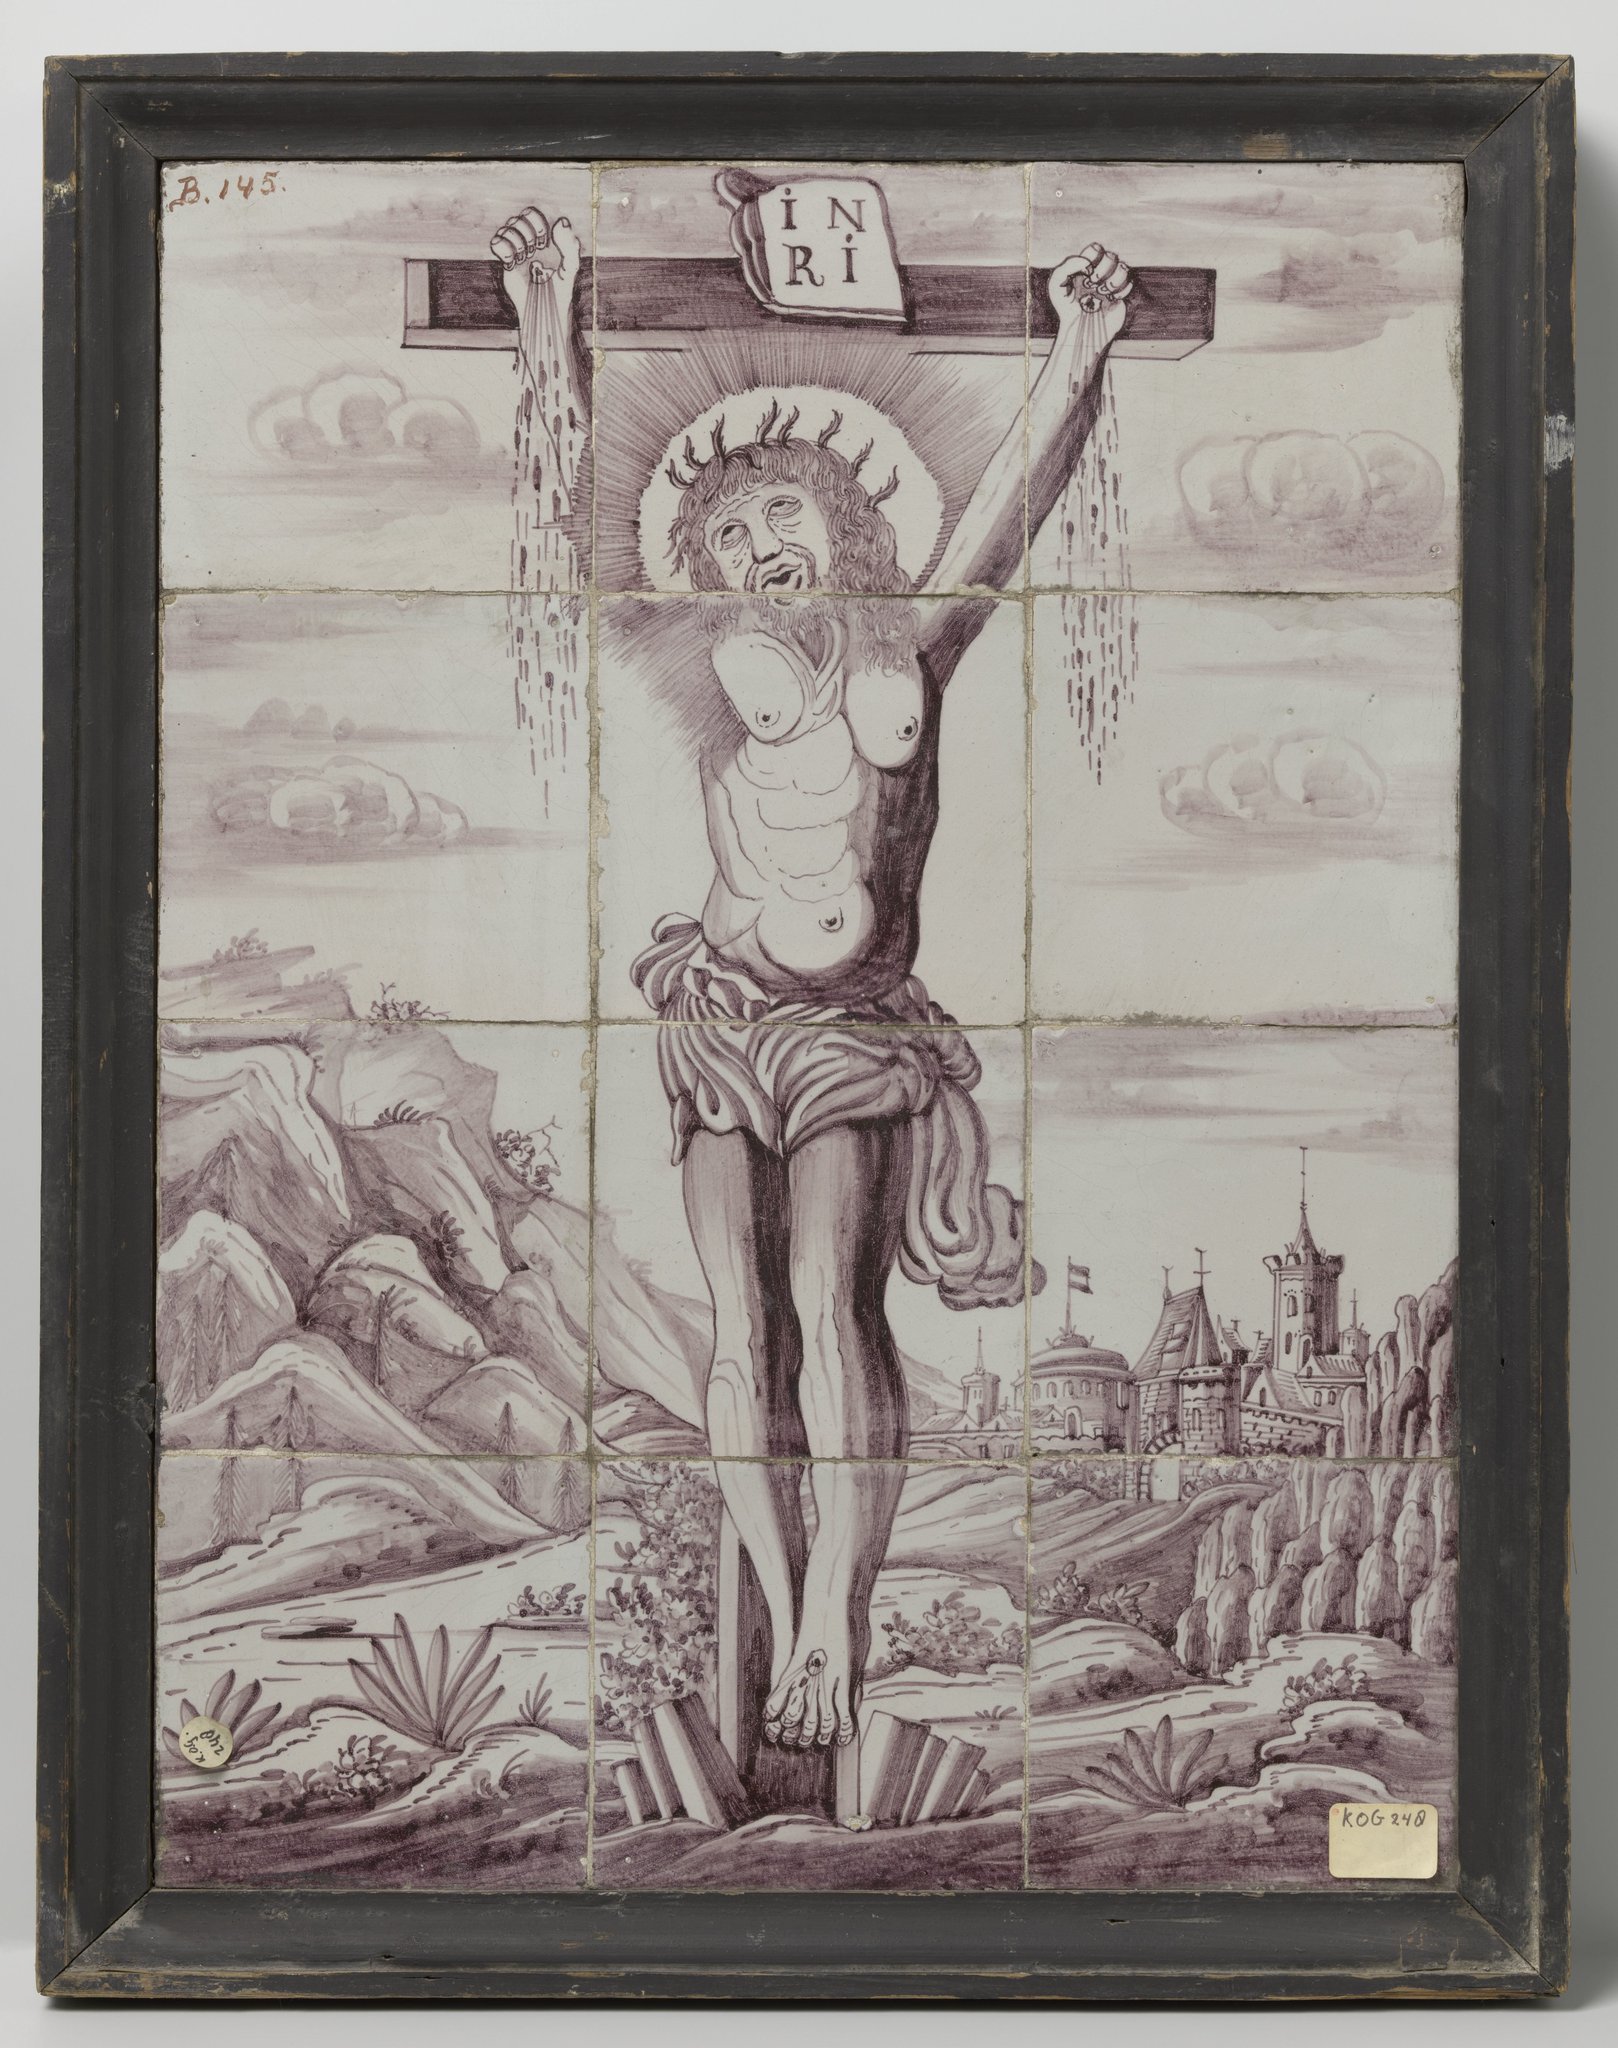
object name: tile tableau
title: Tegeltableau van twaalf tegels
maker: Anonymous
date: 1740-1780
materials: earthenware, glaze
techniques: maiolica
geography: netherlands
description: Tegeltableau van 12 tegels (4 x 3) met Christus aan het kruis. Op de achtergrond een landschap en rechts gebouwen.